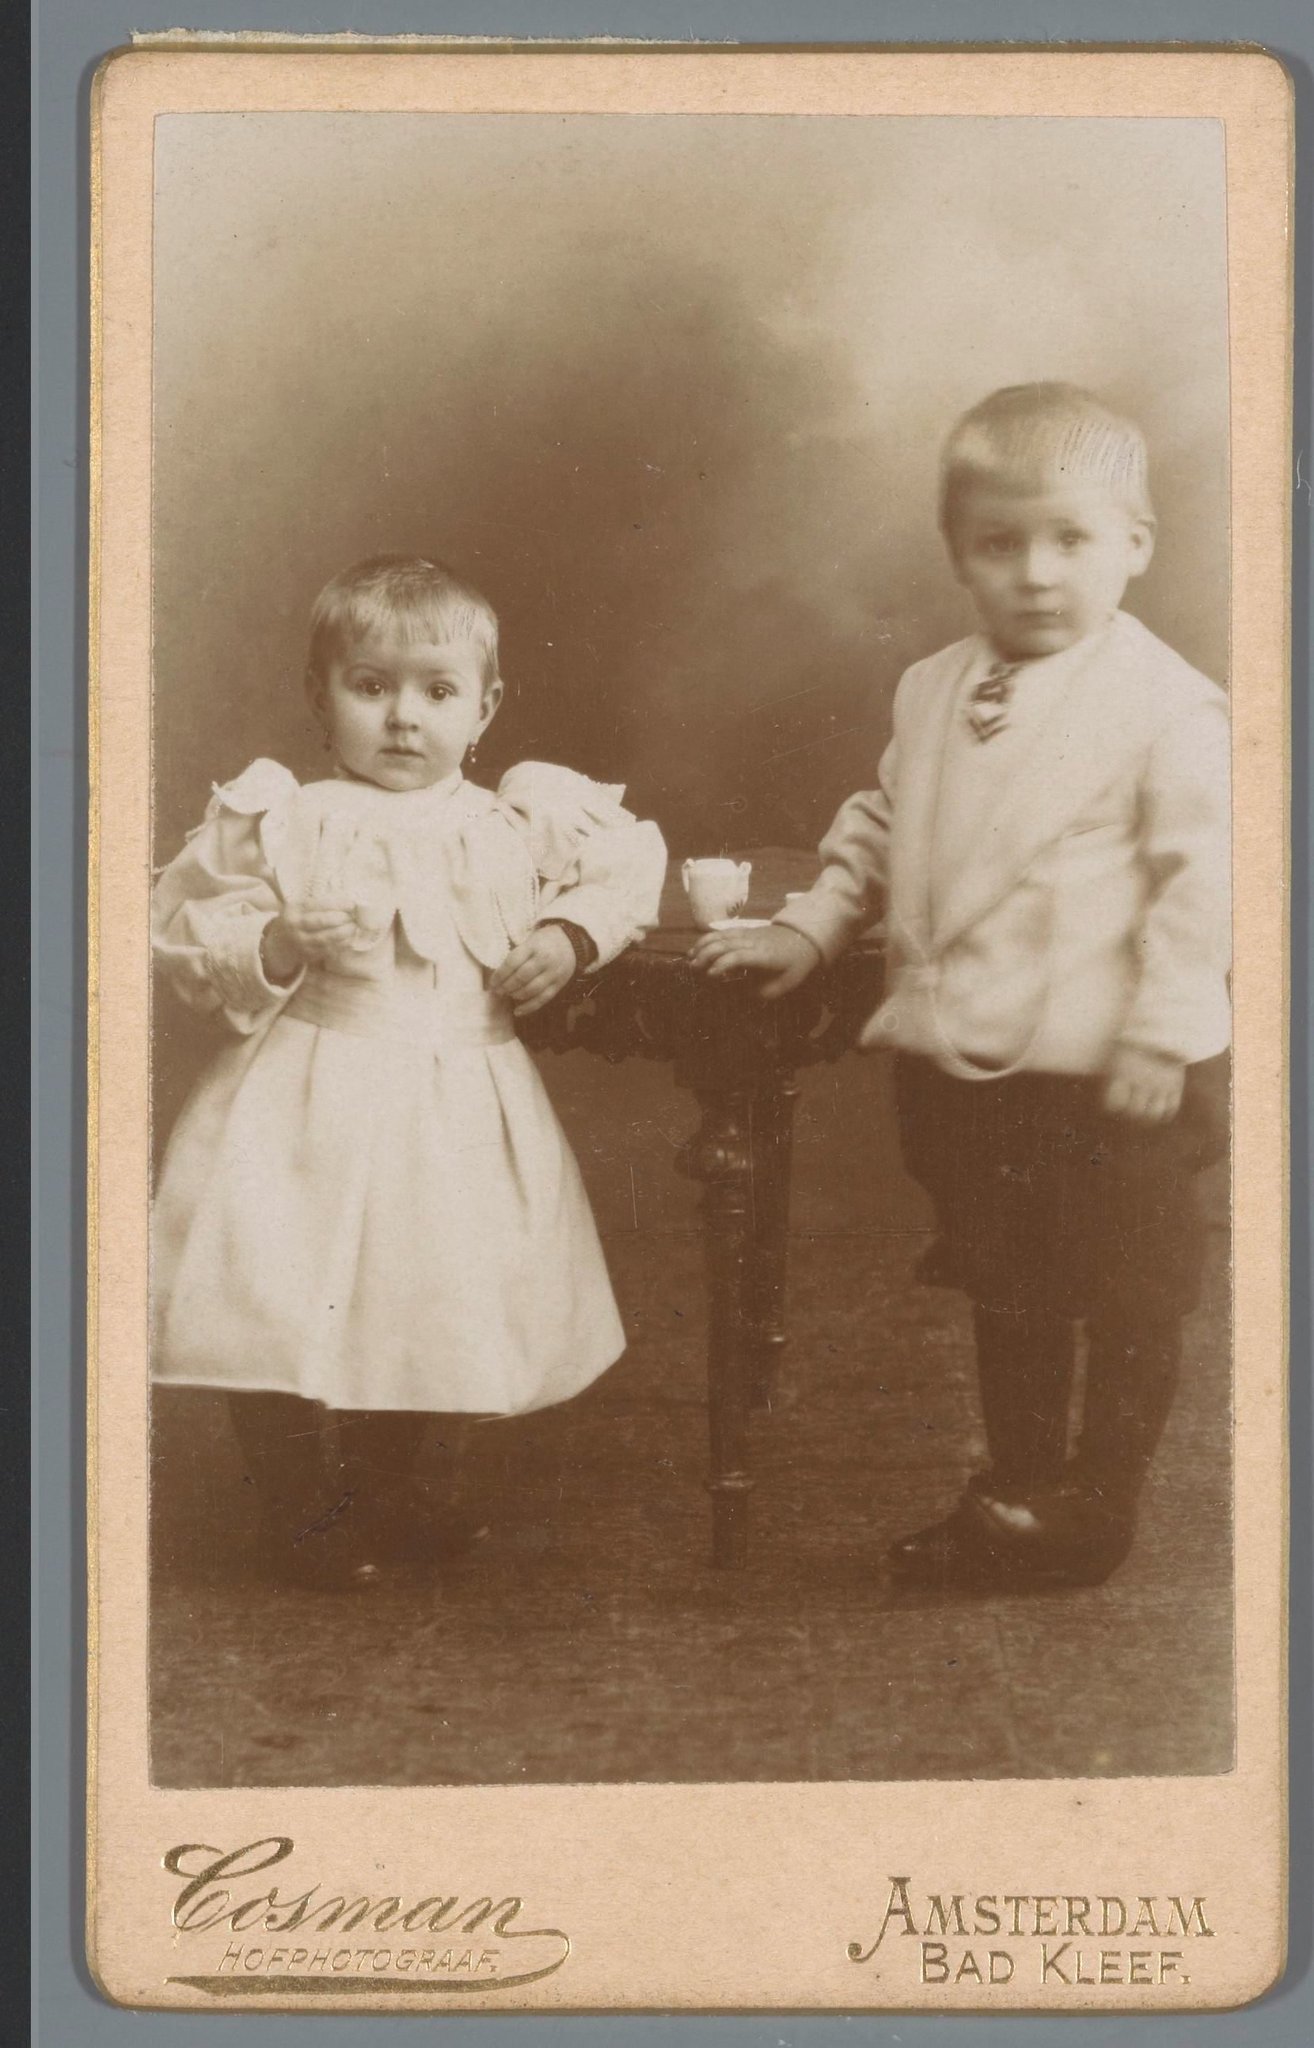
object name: carte de visite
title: Portret van twee onbekende kinderen bij een tafel met serviesgoed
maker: max cosman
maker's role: fotograaf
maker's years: 1852-1894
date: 1891-1903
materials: paper, cardboard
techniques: collodion silver print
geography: amsterdam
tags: toddler, anonymous historical person portrayed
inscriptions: inscription: ‘Specialiteit/ in/ Vergrootingen. Kooldruk Onveranderlijk./ De plaat blijft voor nabestelling bewaard.’, address: ‘Amsterdam/ Koningsplein 1/ hoek Singel./ Galerij 48./ Filiaal: Bad Kleef.’